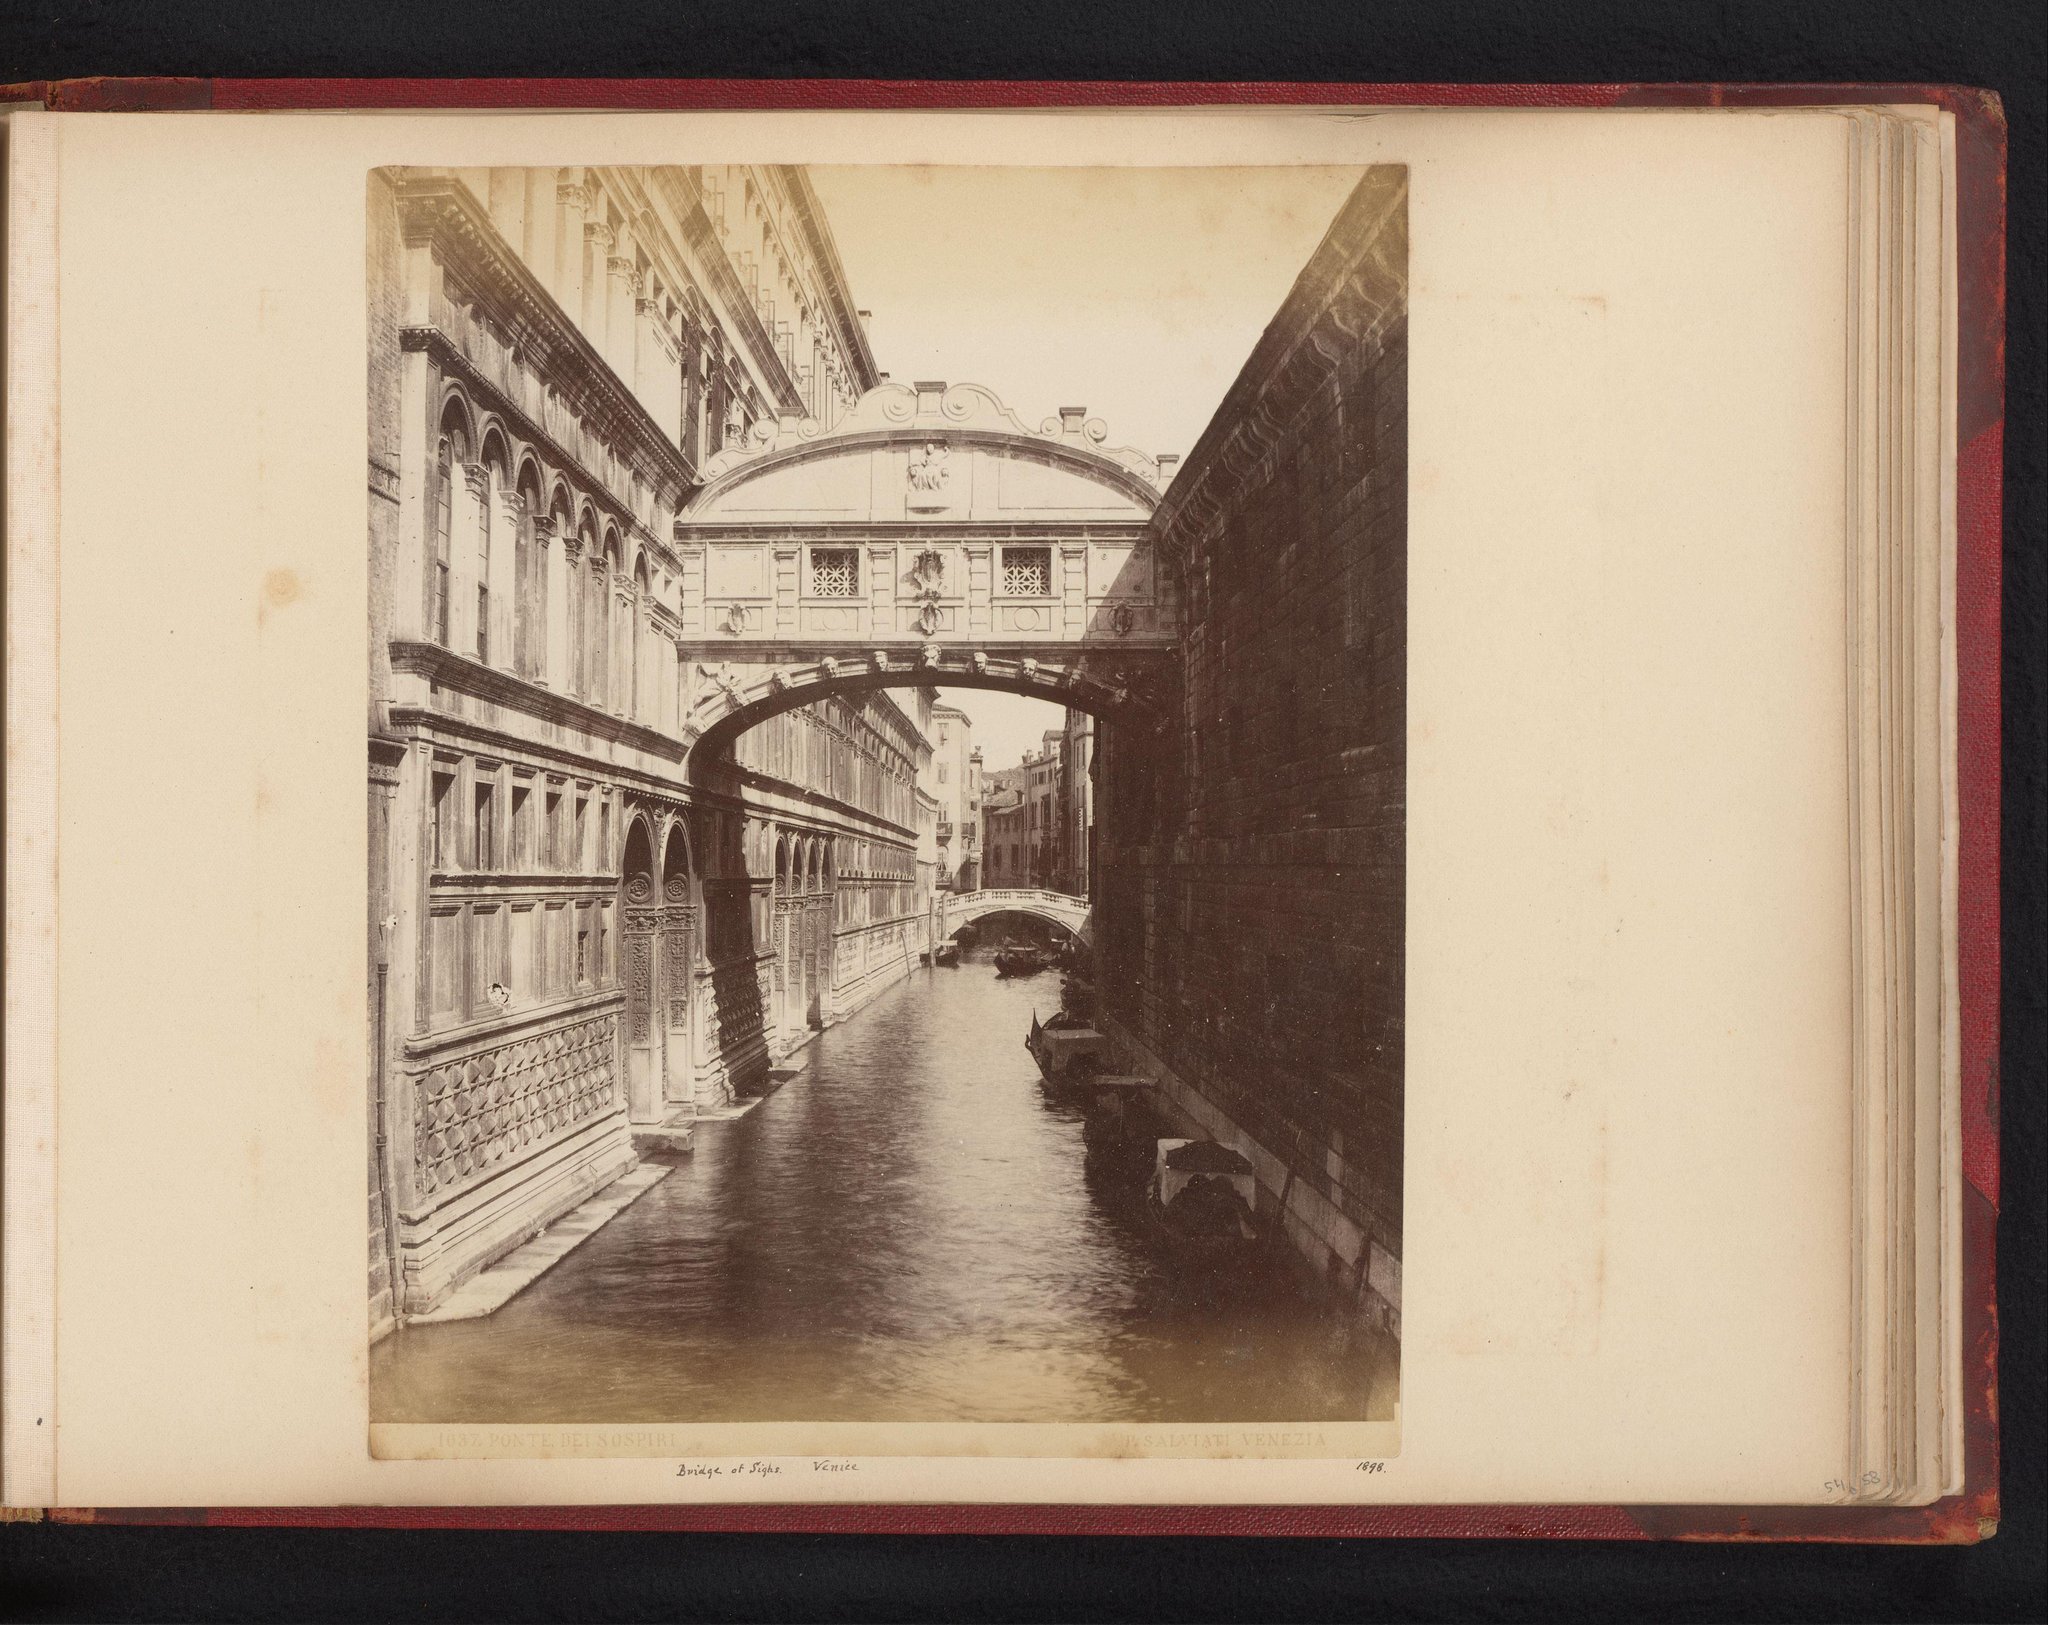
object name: album leaf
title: Gezicht op de Brug der Zuchten te Venetië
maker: paolo salviati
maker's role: fotograaf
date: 1898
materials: photographic support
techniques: albumen print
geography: venice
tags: bridge in city across river, canal, etc. - ii - ideal city, canals, waters (in city) (+ city(-scape) with figures, staffage)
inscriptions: inscription: ‘1037. Ponte dei Sospiri/ P. Salviati Venezia’, annotation: ‘Bridge of Sighs. Venice/ 1898’